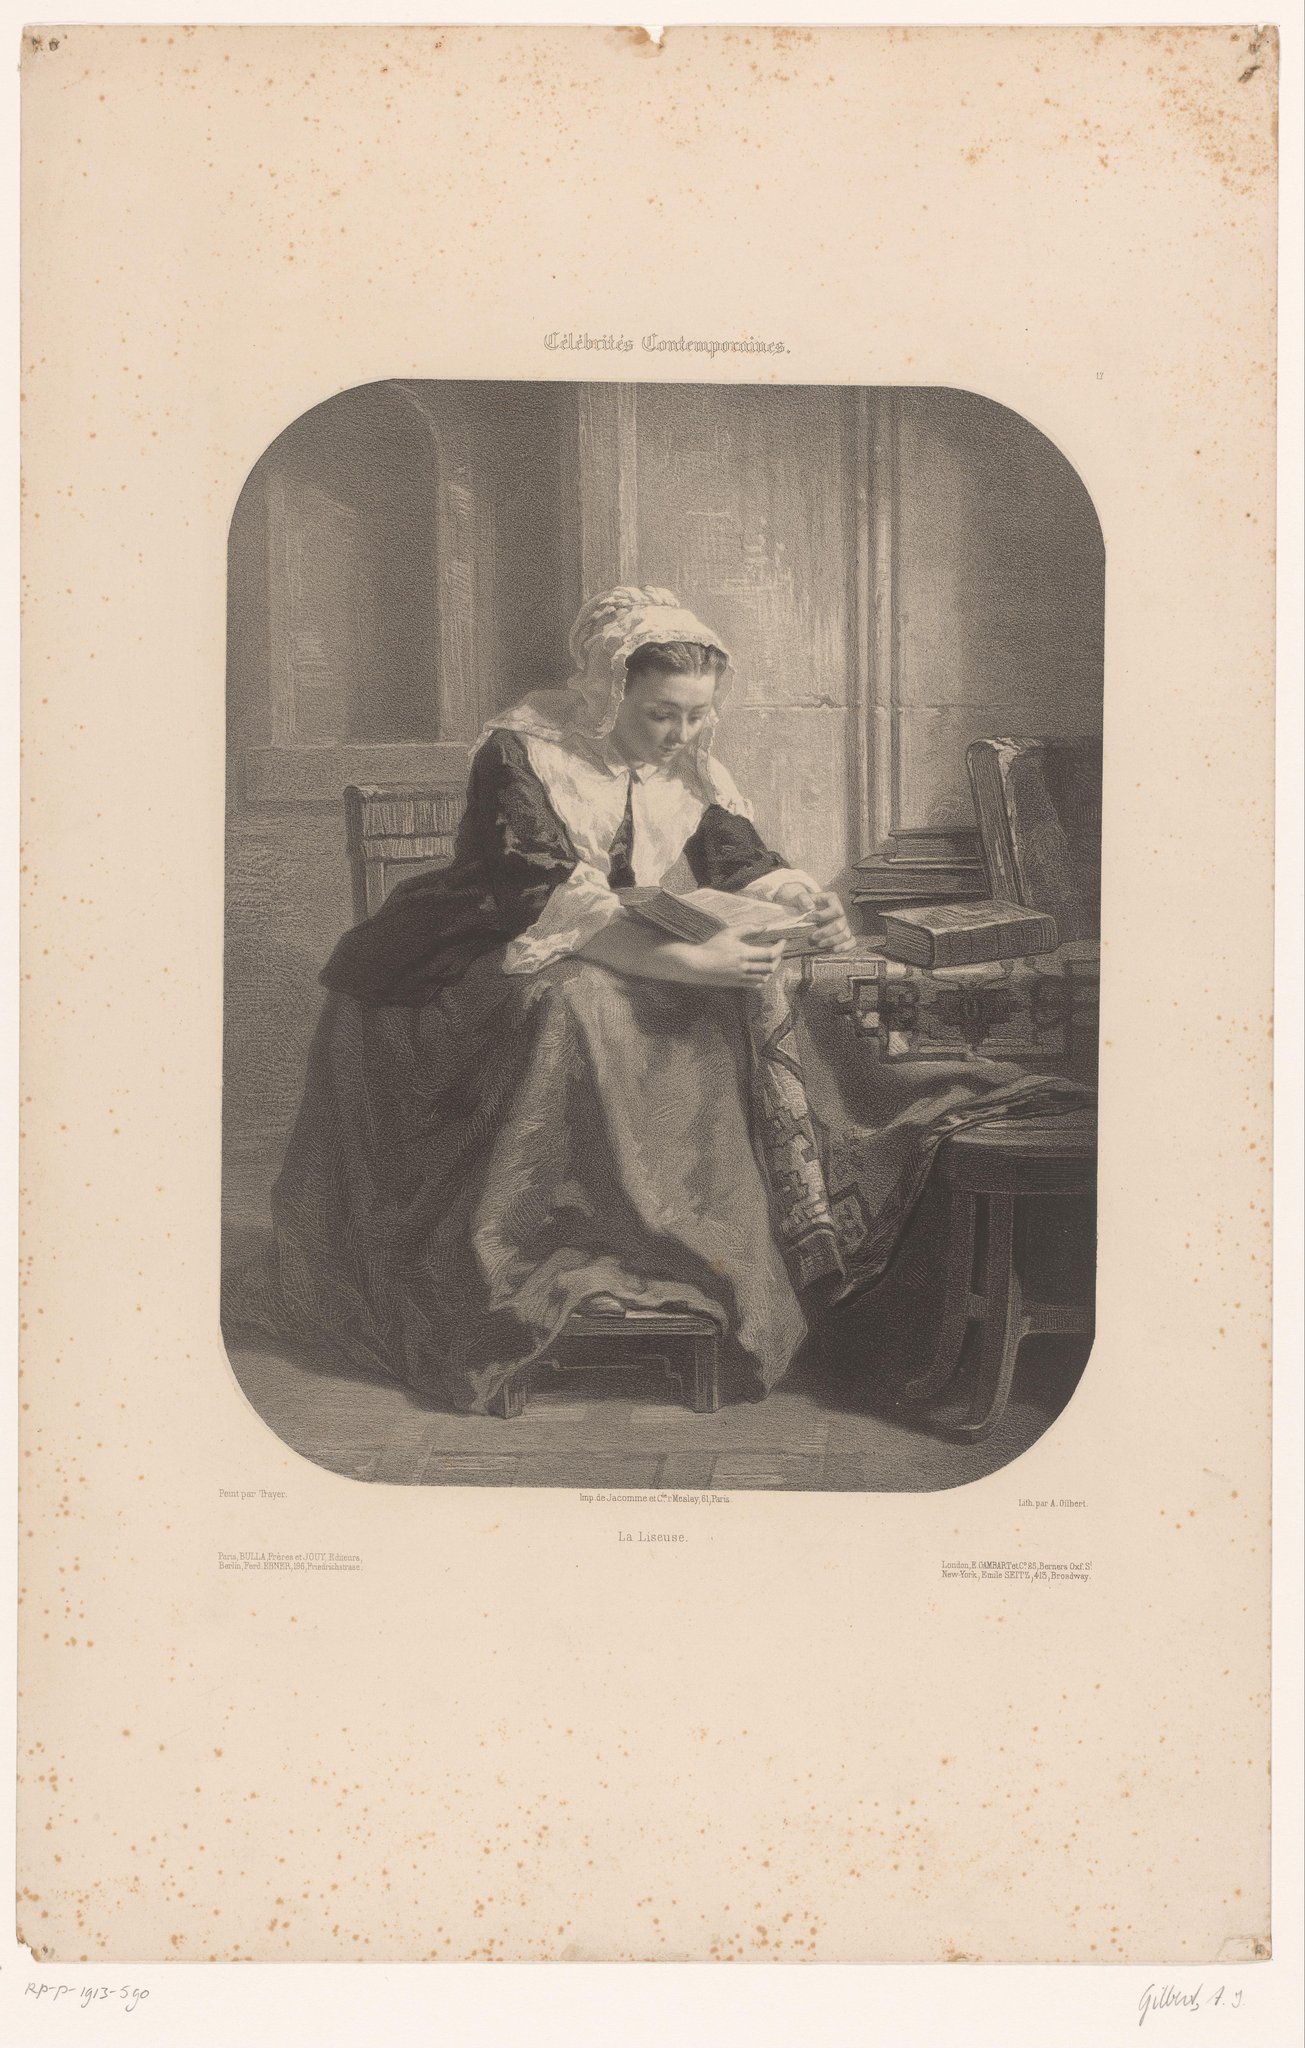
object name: print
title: Werken van bekende hedendaagse kunstenaars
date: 1854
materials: paper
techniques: lithograph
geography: paris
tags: reading, sitting figure - aa - female human figure, book - mm - book open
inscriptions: collector's mark: Lugt 2233